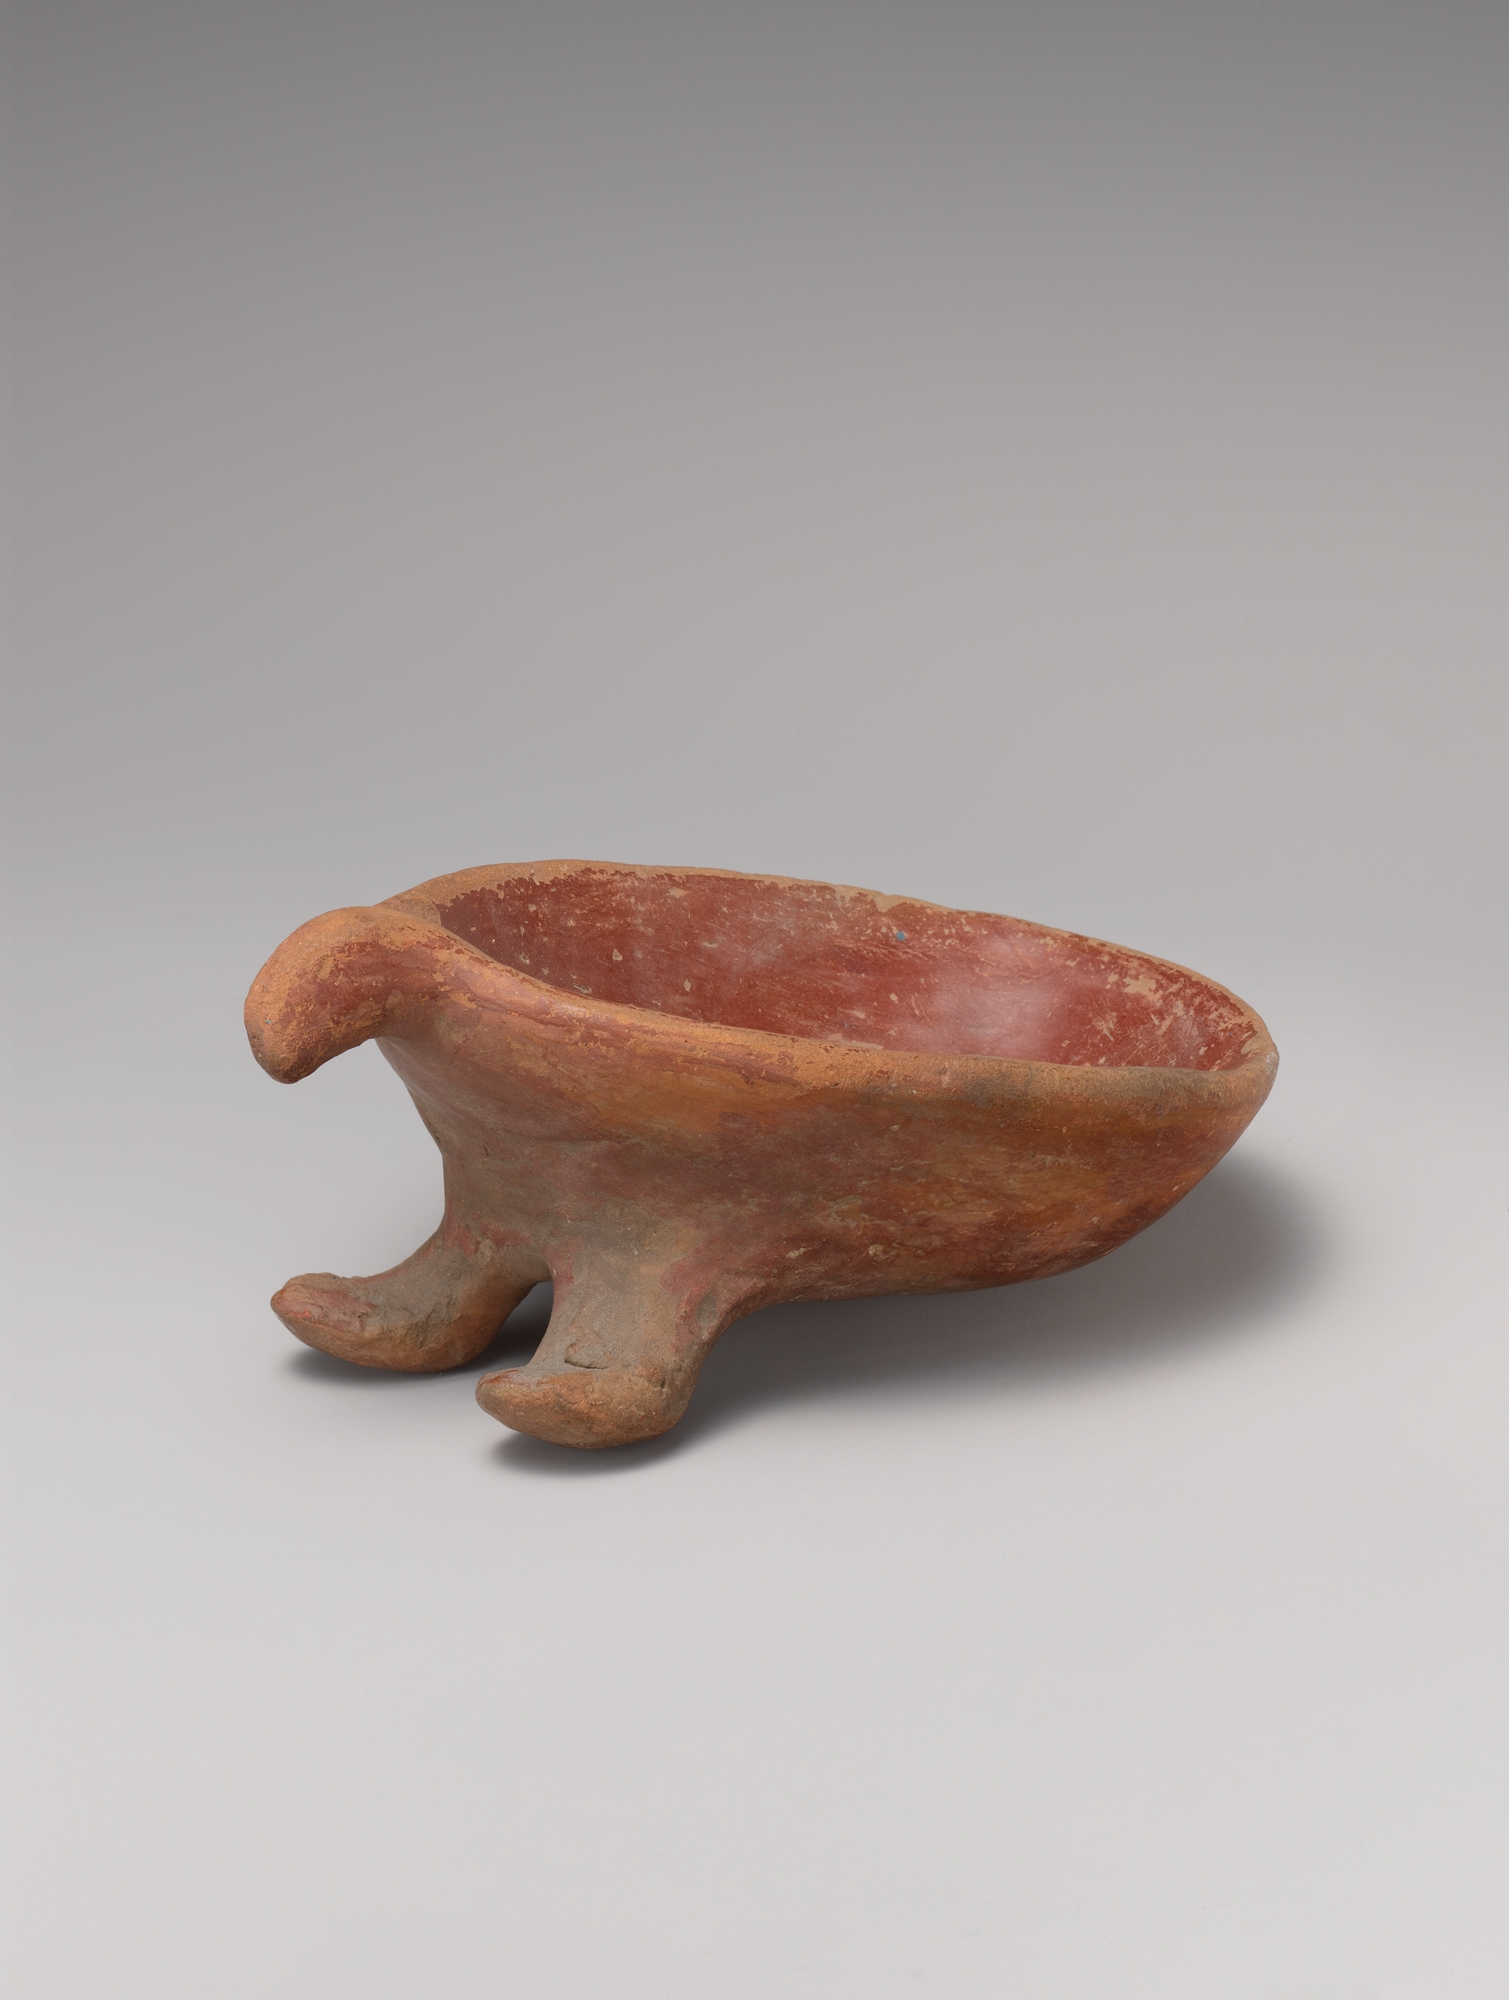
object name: bowl, red polished ware, turtle shaped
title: Bowl in the form of a turtle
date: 3900-3500 BCE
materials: pottery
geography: egypt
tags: turtles